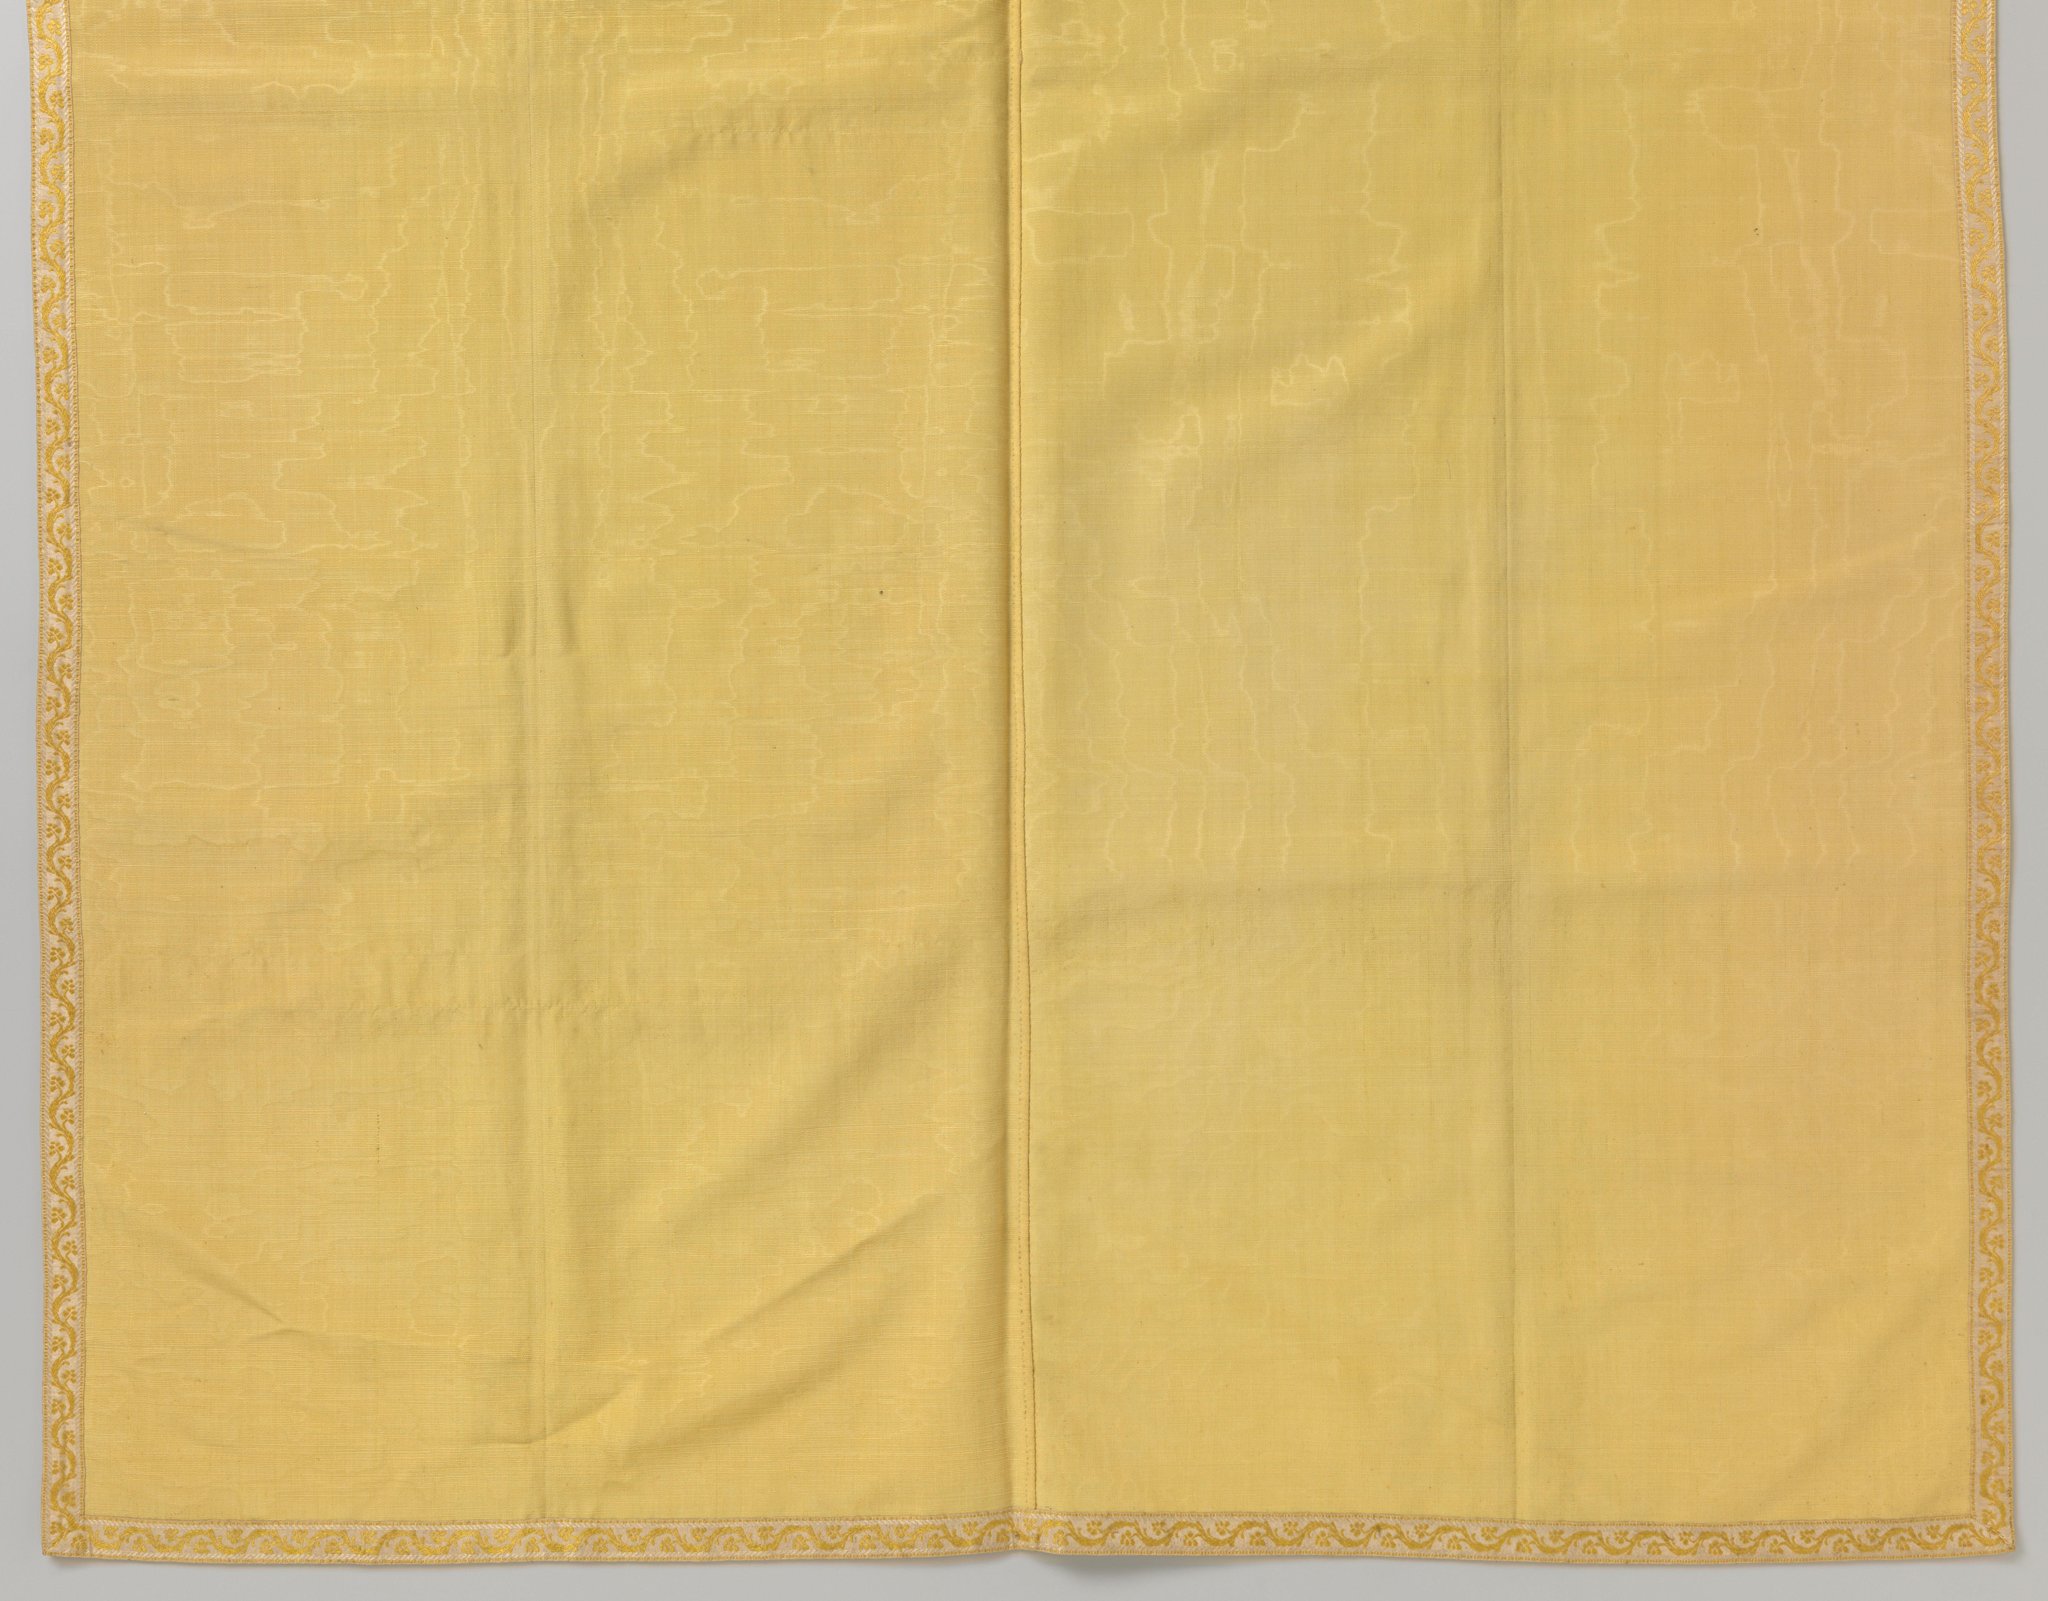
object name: bed curtain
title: Gordijn van een bedgarnituur van gewaterde gele wol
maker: Anonymous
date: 1776-1800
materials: silk, wool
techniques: moire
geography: northern netherlands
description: Gordijn van een bedgarnituur van gewaterde gele wol versierd met opgenaaid passement van zijde met een gele slingerende voluut op een wit fond. Voorzien van twee metalen ringen.